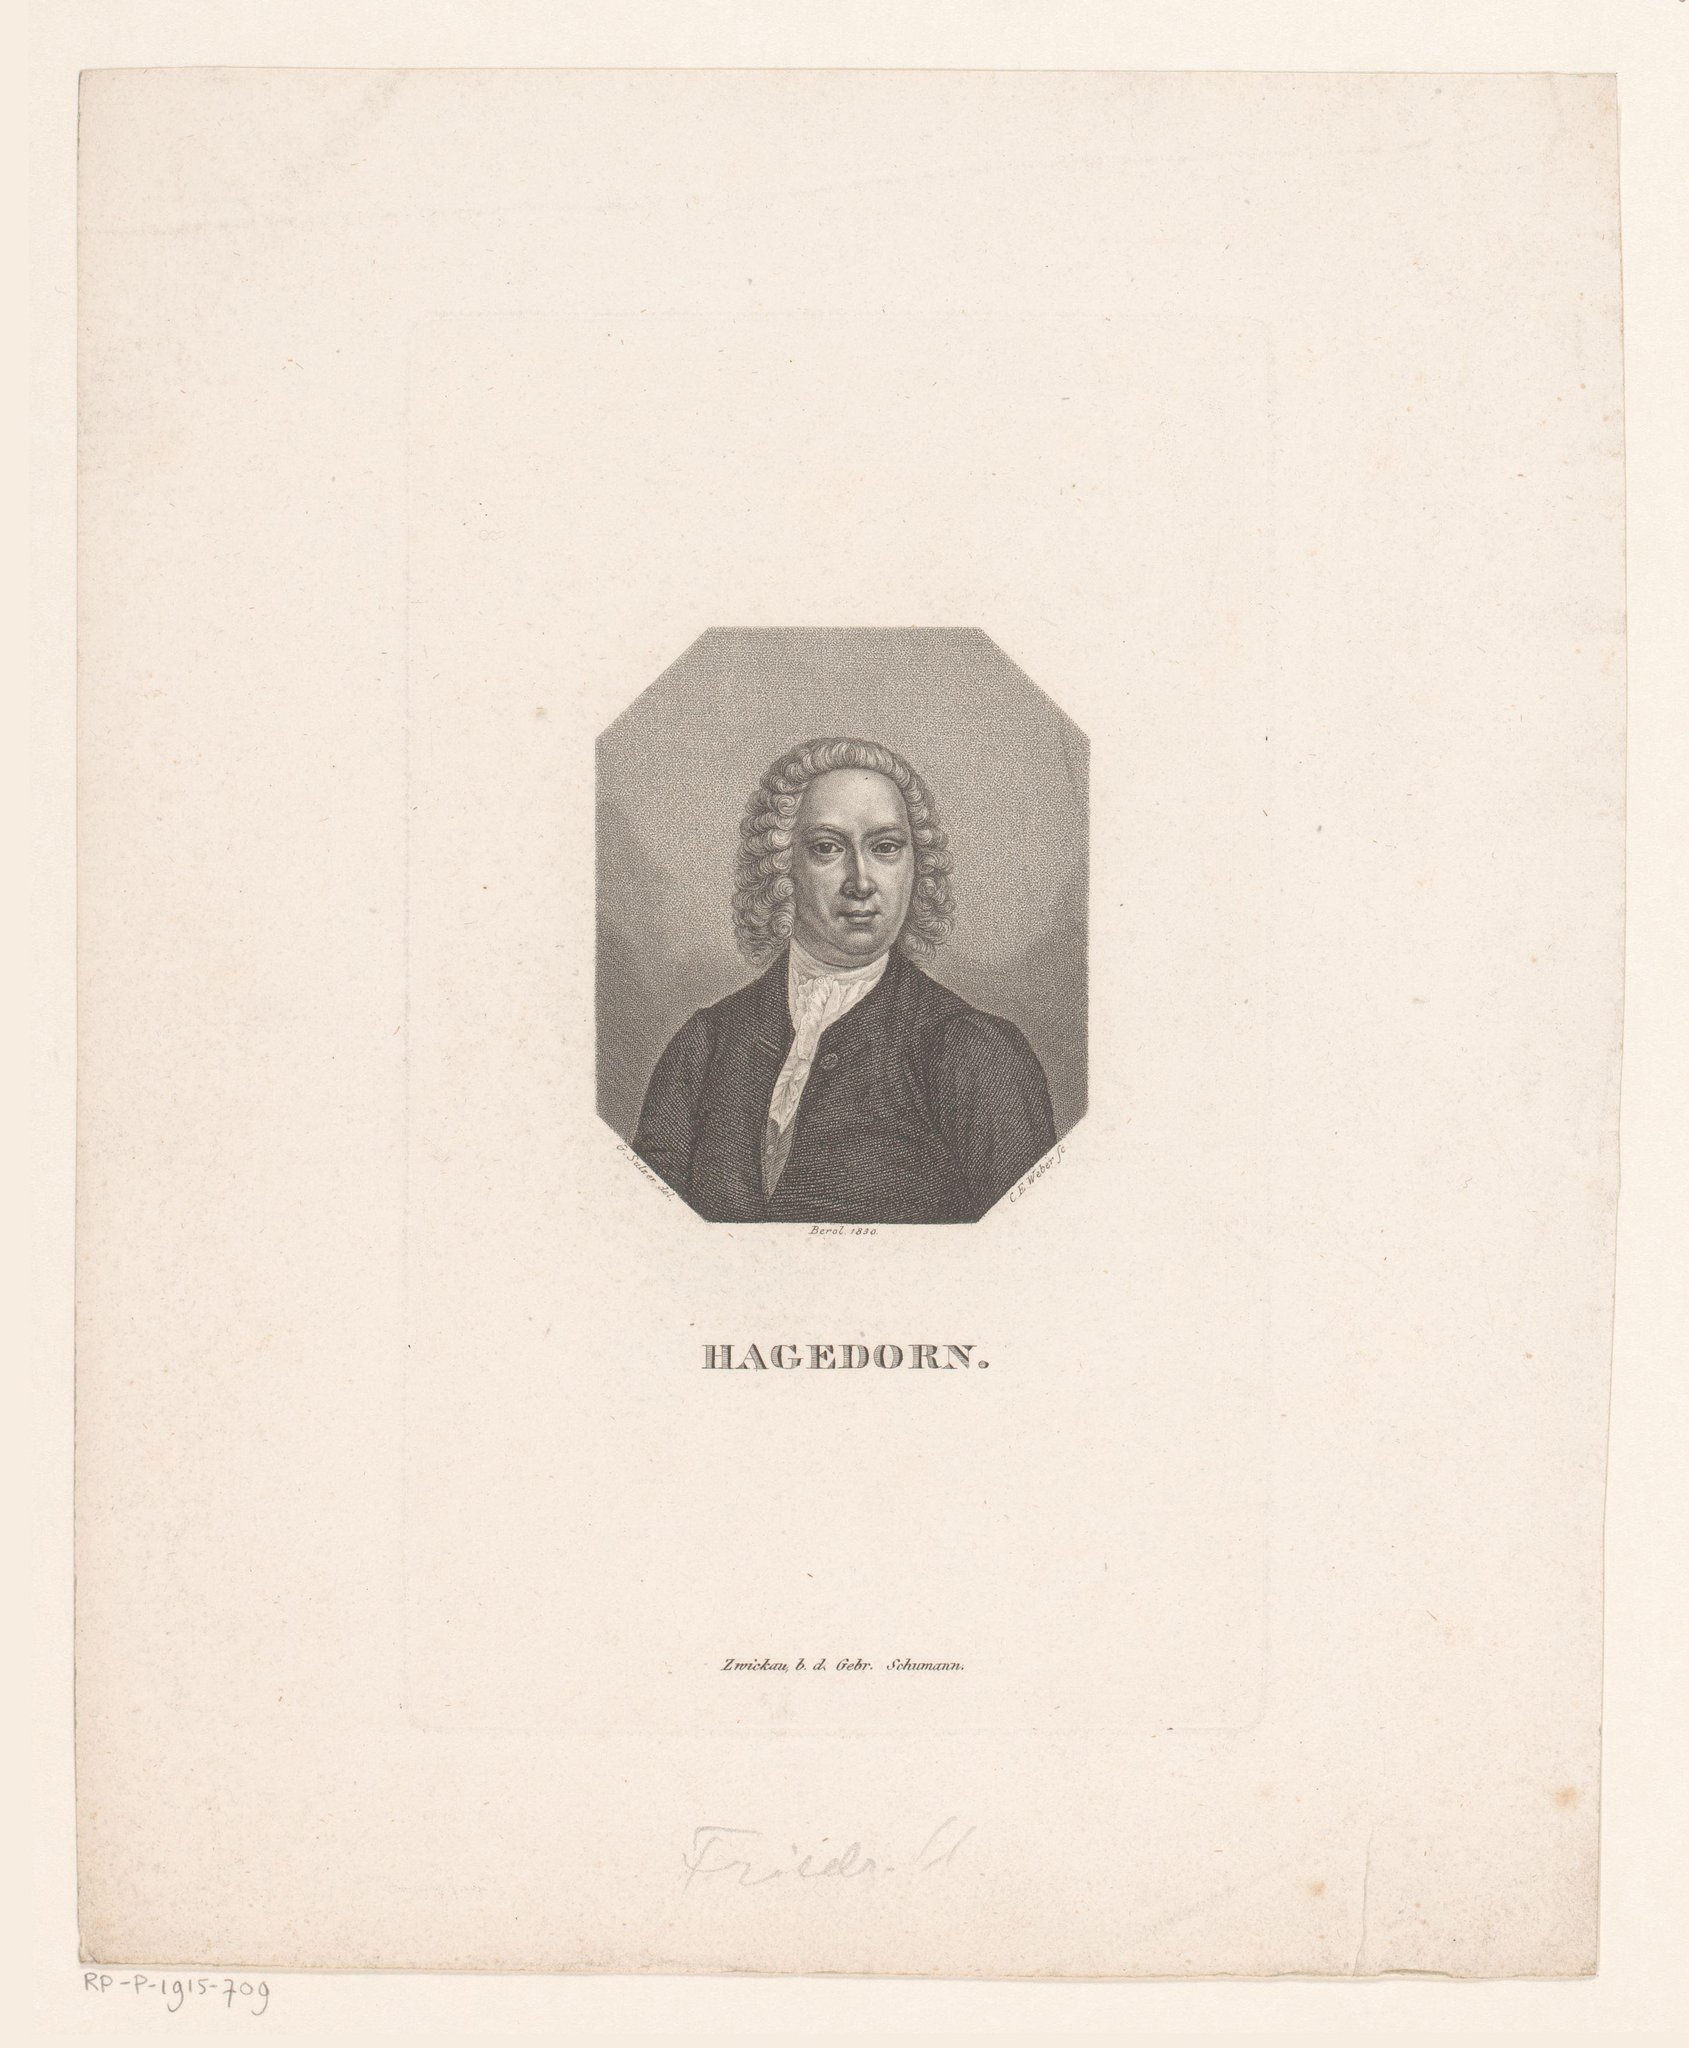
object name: print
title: Portret van Friedrich von Hagedorn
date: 1830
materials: paper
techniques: stippling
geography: zwickau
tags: historical persons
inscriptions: collector's mark: Lugt 2228